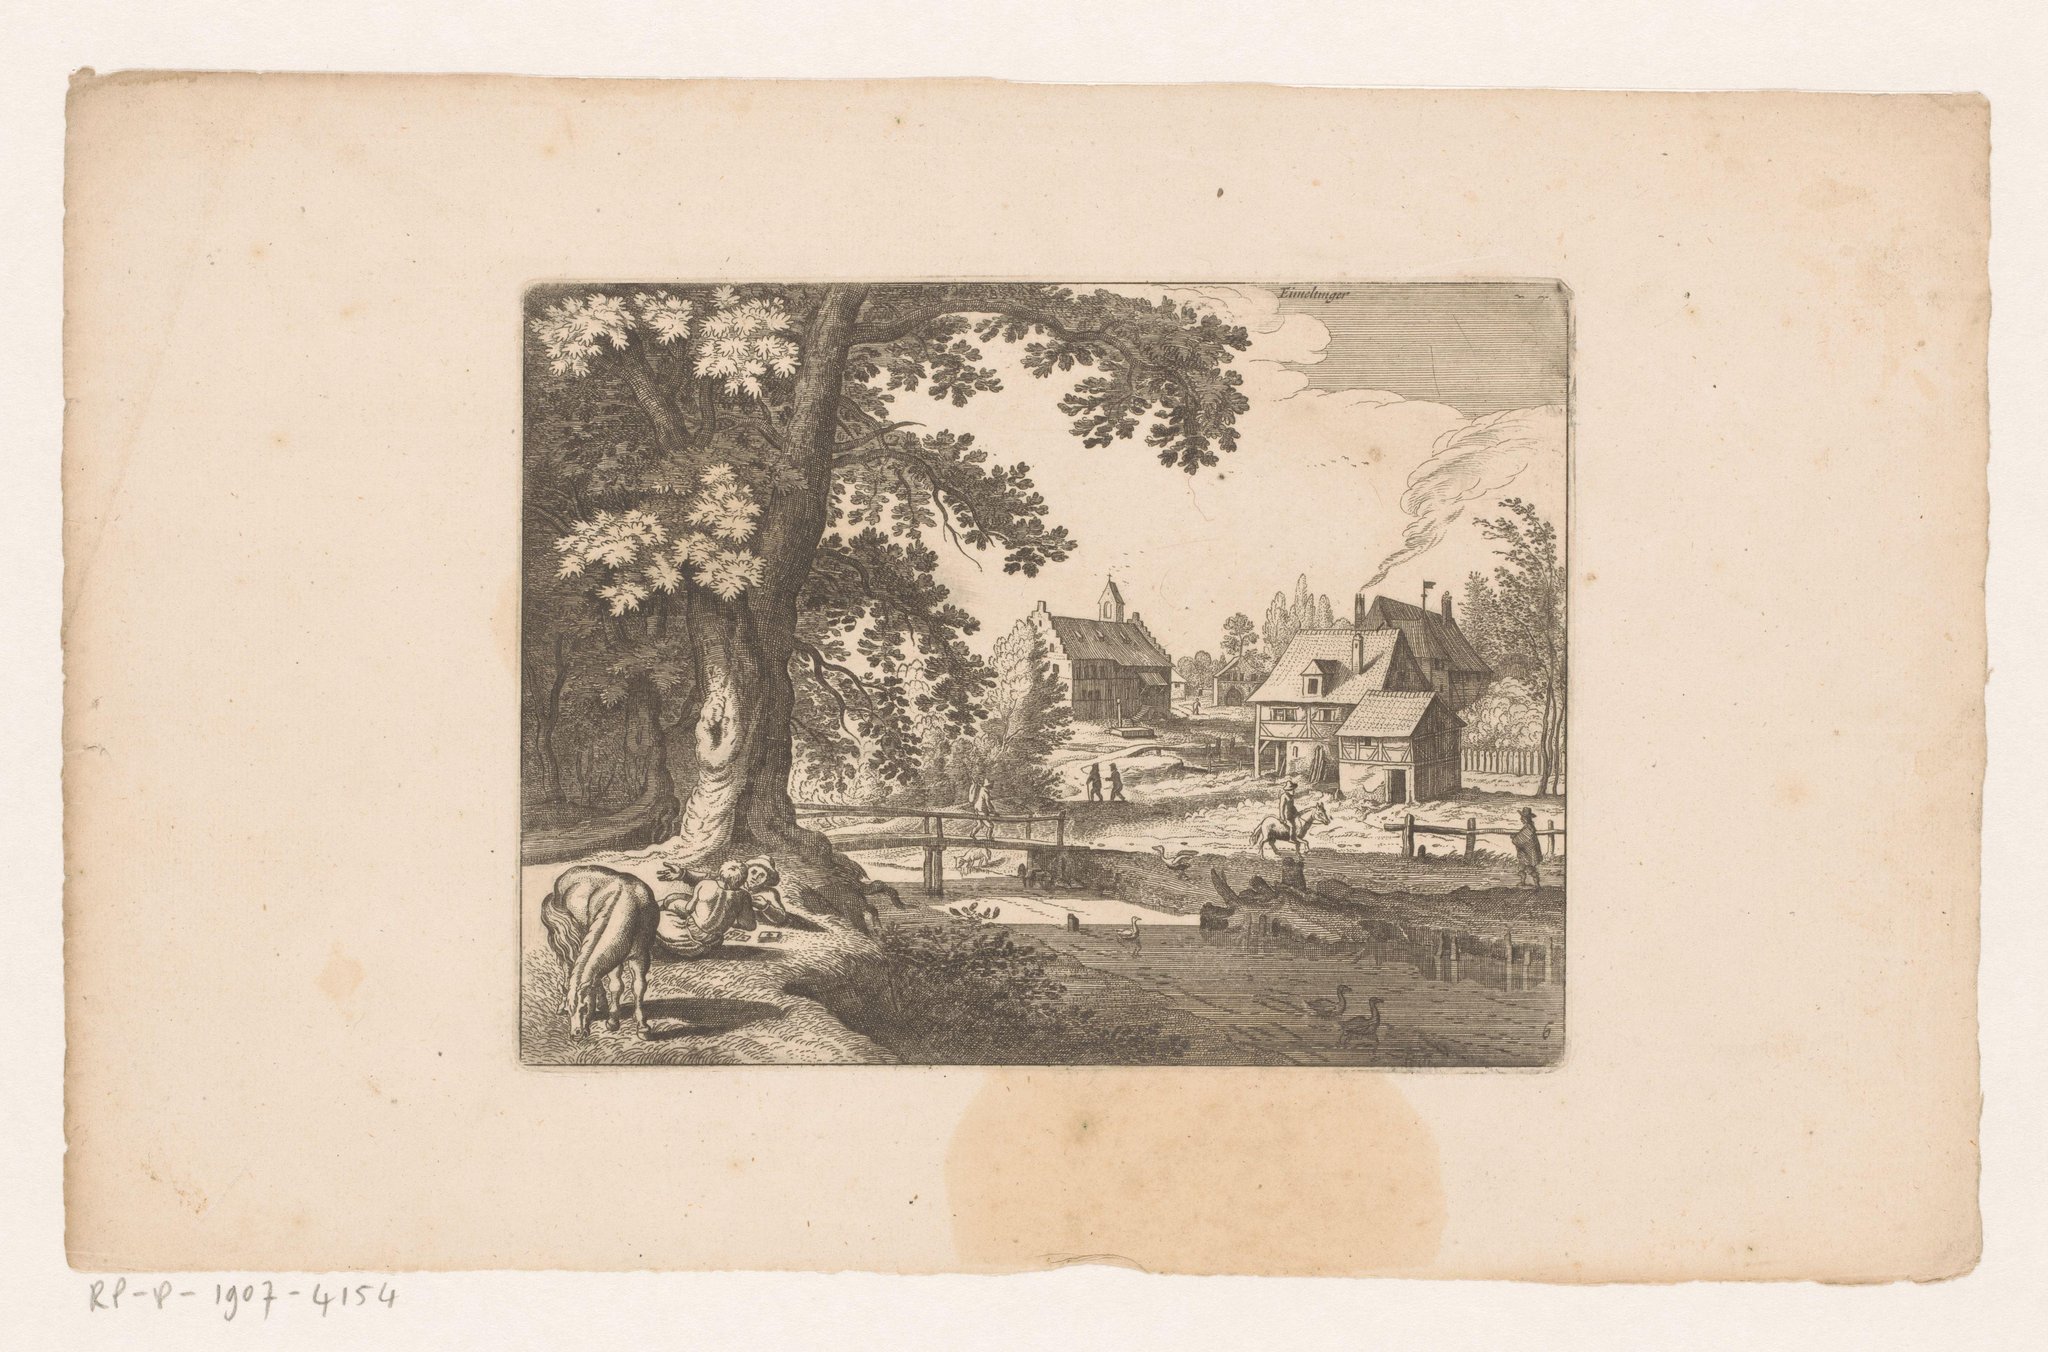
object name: print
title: Zes landschappen naar Matthäus Merian I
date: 1628-1679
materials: paper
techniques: etching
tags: city-view, and landscape with man-made constructions, horse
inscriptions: collector's mark: Lugt 2228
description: Kopie in dezelfde richting naar de prent van Matthäus Merian I (Hollstein 332). Deze prent heeft het nummer 6 rechtsonder gedrukt.